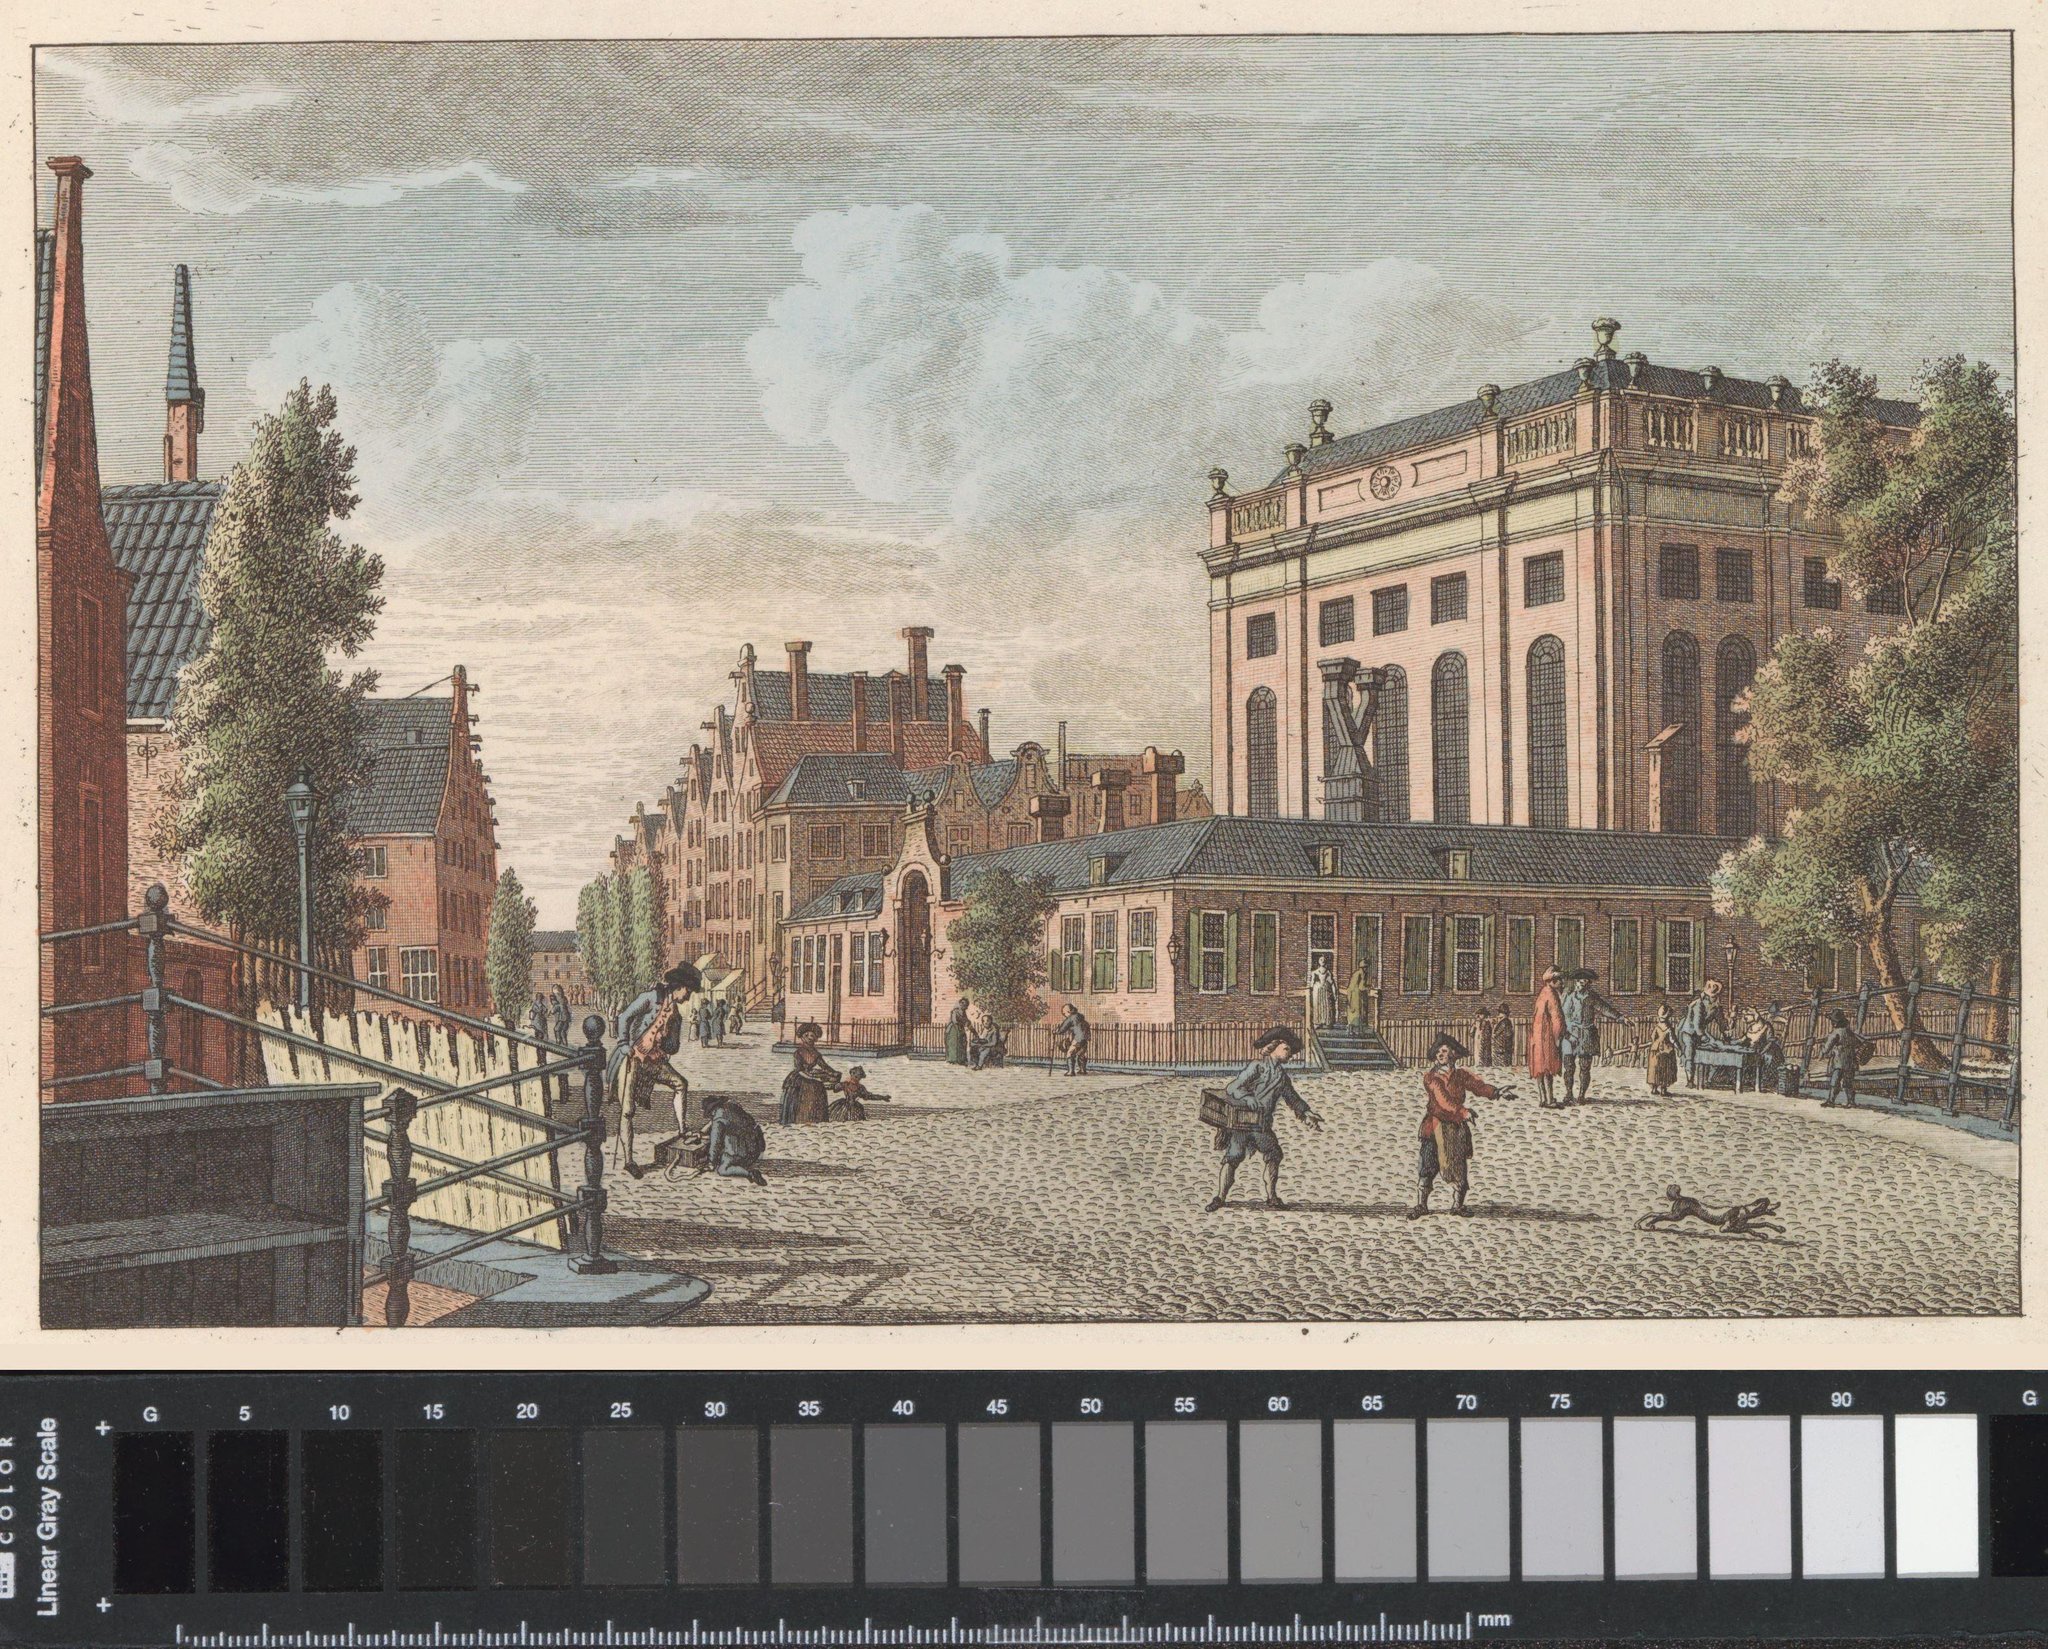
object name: print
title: Gezicht op de Portugese Synagoge te Amsterdam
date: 1786-1792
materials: paper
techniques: engraving, etching, hand coloring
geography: amsterdam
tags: the synagogue (as building and place of worship ~ jewish religion)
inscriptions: inscription: ‘chez E: Maaskamp à Amsterdam’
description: Huidige staat van prent uitgegeven als onderdeel van een plaatwerk uit ca. 1824-1825 met 74 (ongenummerde) platen van de belangrijkste topografische gezichten en verschillende zeden en gewoonten in het Verenigd Koninkrijk der Nederlanden, getiteld 'Tableau des principales vues des palais et édifices : représentations et des coutumes et usages, dans les provinces septentrionales du Royaume des Pays-Bas'. Eerdere staat gebruikt in: Vaderlandsche gezichten, of afbeeldingen van den tegenwoordigen staat der Vereenigde Nederlanden (…). Amsterdam: Hendrik Gartman, Willem Vermandel en Jan Willem Smit, 1786-1792. Uitgegeven in afleveringen met ieder een eigen bifolium en inhoudsopgave. Alle prenten in deze publicatie zijn gegraveerd door Carel Frederik Bendorp (I) en, in de meeste gevallen, gebaseerd op tekeningen van Jan Bulthuis.